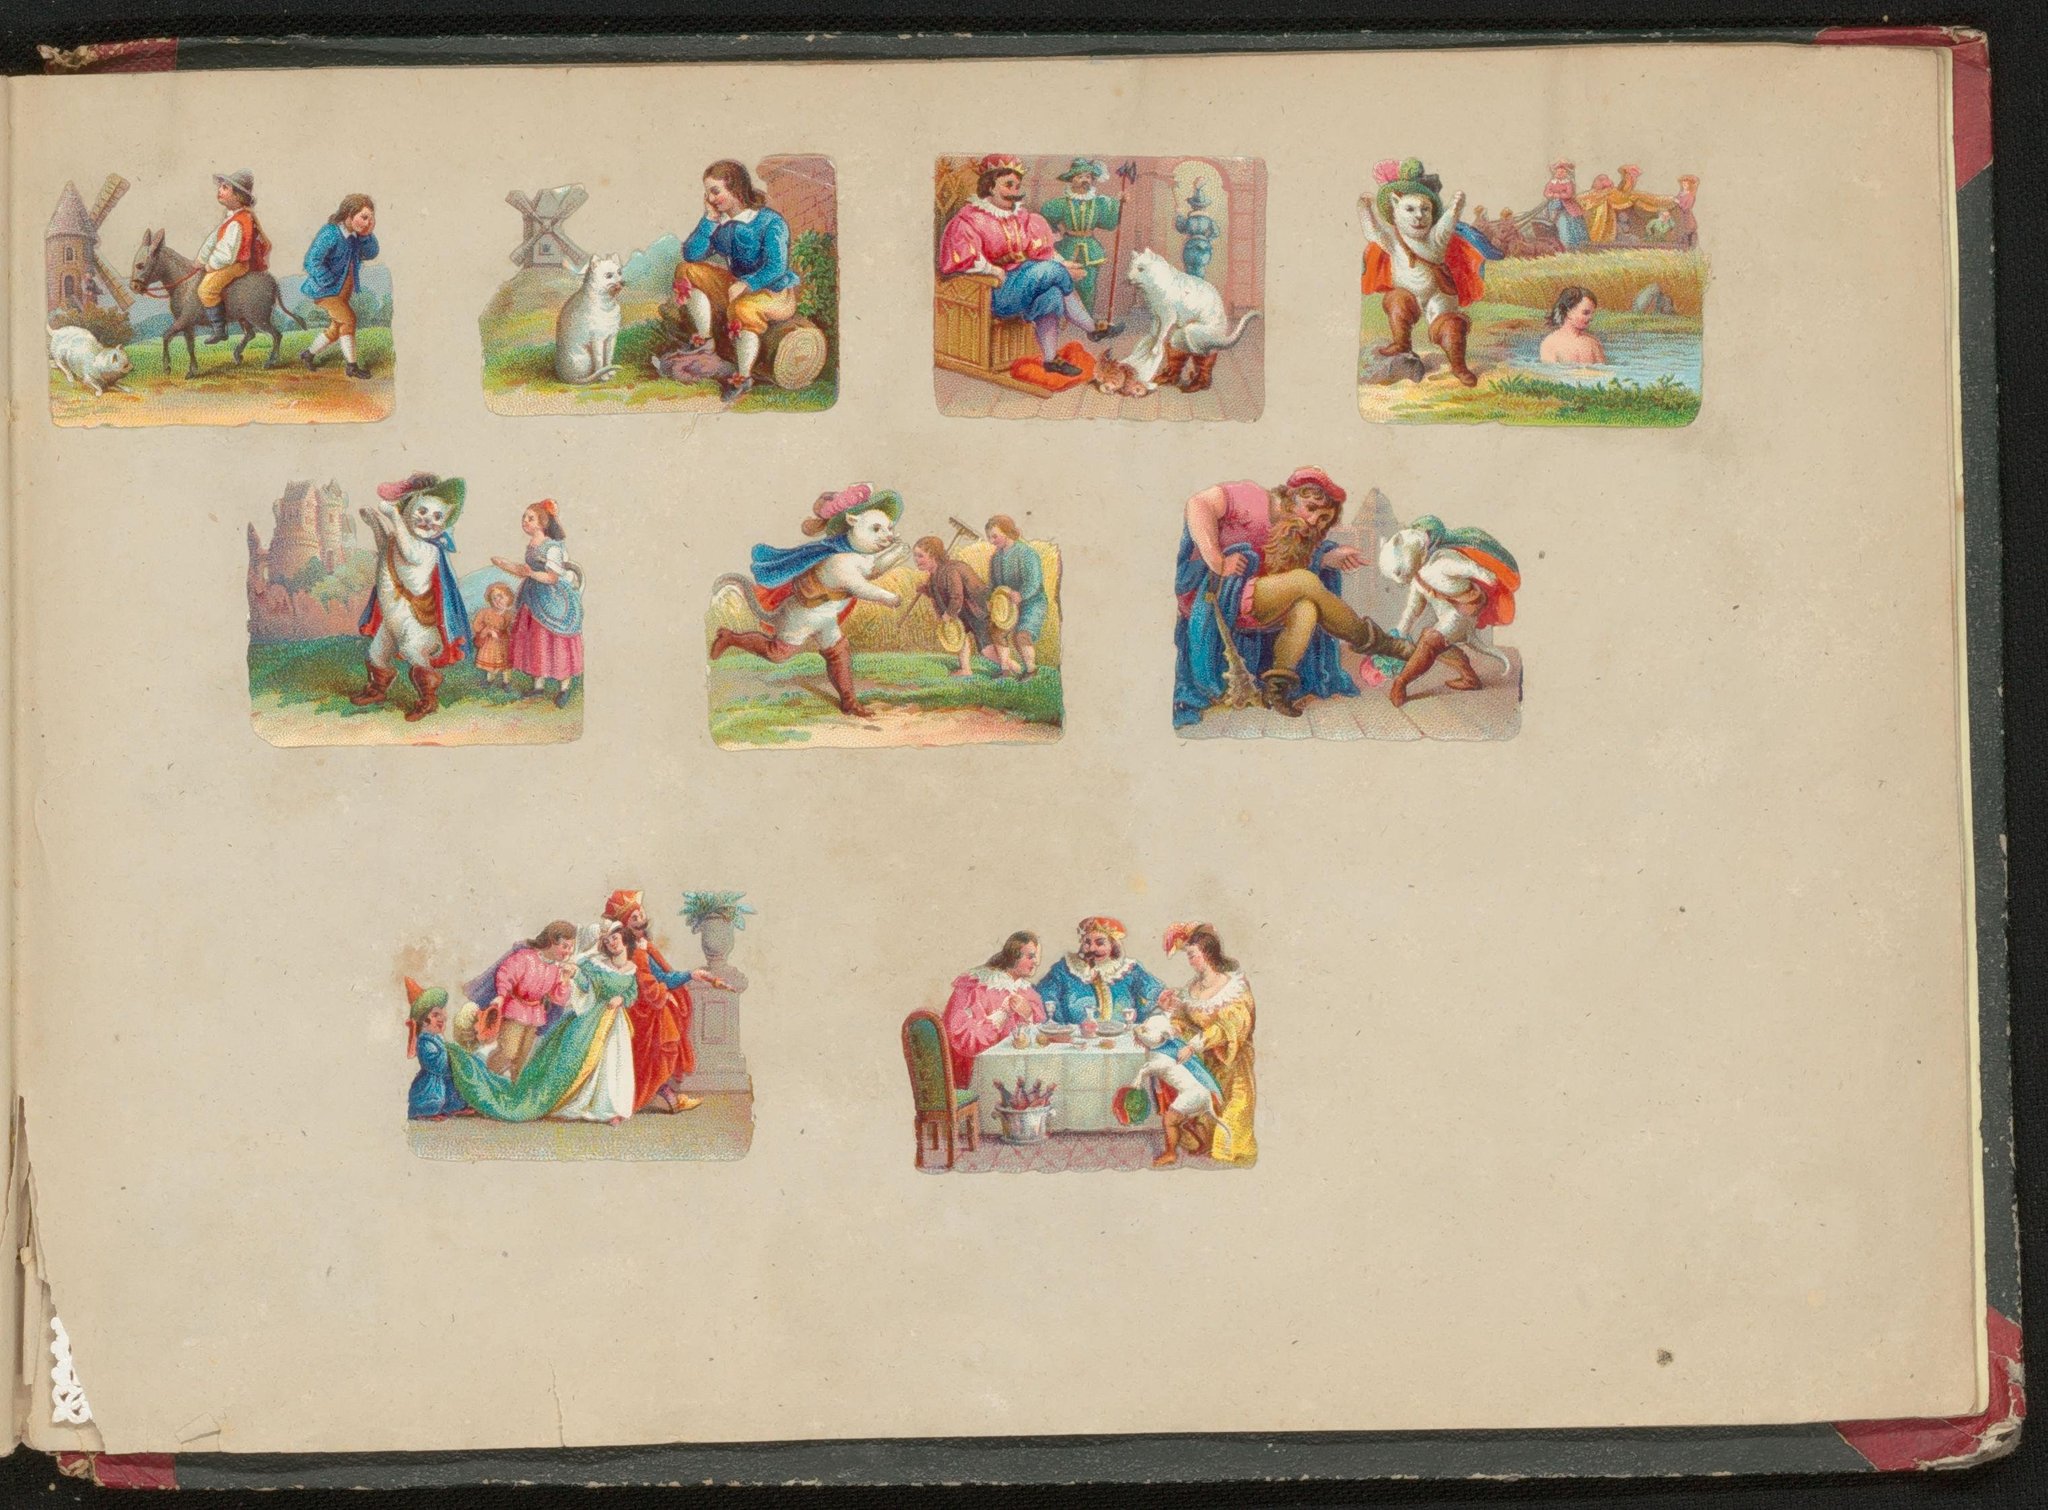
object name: album leaf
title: Albumblad met 9 plakplaatjes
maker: Anonymous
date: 1880-1910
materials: paper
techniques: chromolithography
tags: tales and fairy tales: puss in boots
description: Albumblad met 9 plakplaatjes van het sprookje van de Gelaarsde Kat. Onderdeel van het plakboek met 38 bladen gevuld met plakplaatjes, poesieplaatjes en uitgeknipte en ingeplakte fragmenten van prenten. Onderwerpsrubrieken binnen de Atlas Zeden en Gewoonten: Schoone kunsten, Varia.